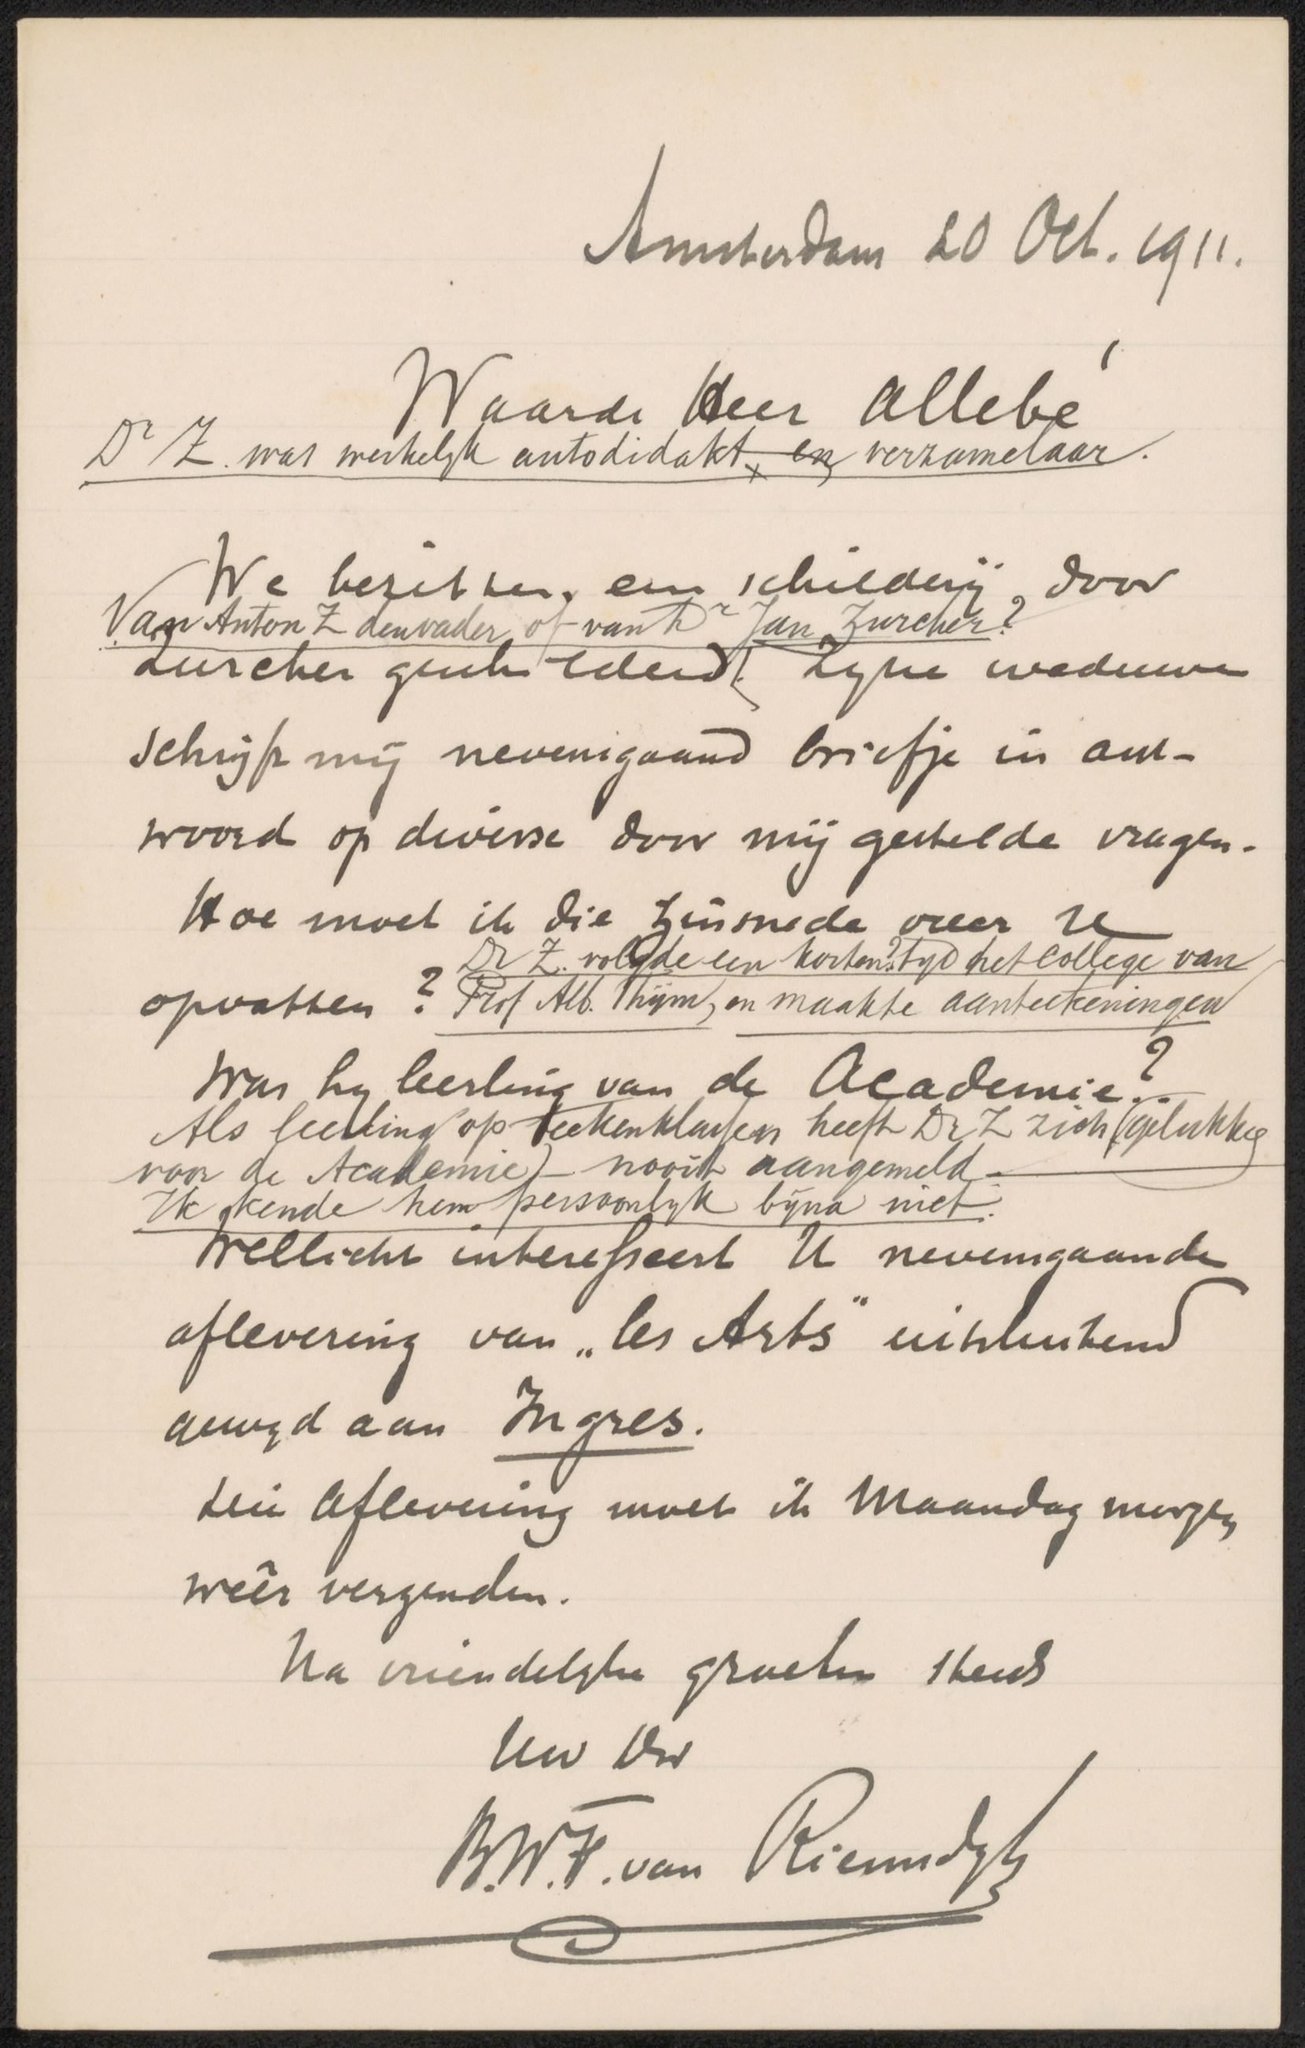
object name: letter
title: Brief aan August Allebé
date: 1911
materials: ink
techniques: pen, writing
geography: amsterdam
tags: draughtsman, august allebé, the hague, painter, jan zürcher, antonie frederik zürcher, painting (including book-illumination, miniature-painting)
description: Brief bevat aantekeningen van August Allebé.